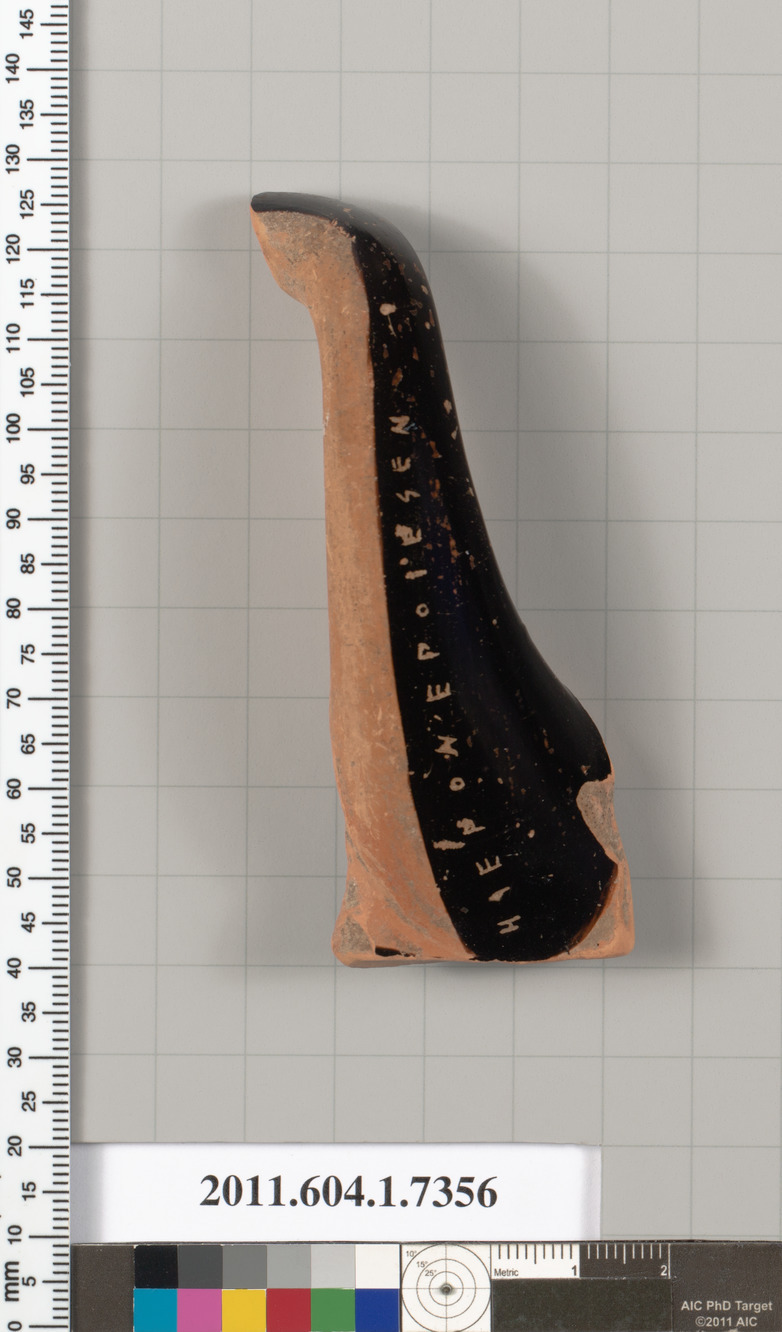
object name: kylix fragment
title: Terracotta fragment of a kylix (drinking cup)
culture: greek, attic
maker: makron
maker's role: artist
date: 500-480 BCE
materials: terracotta